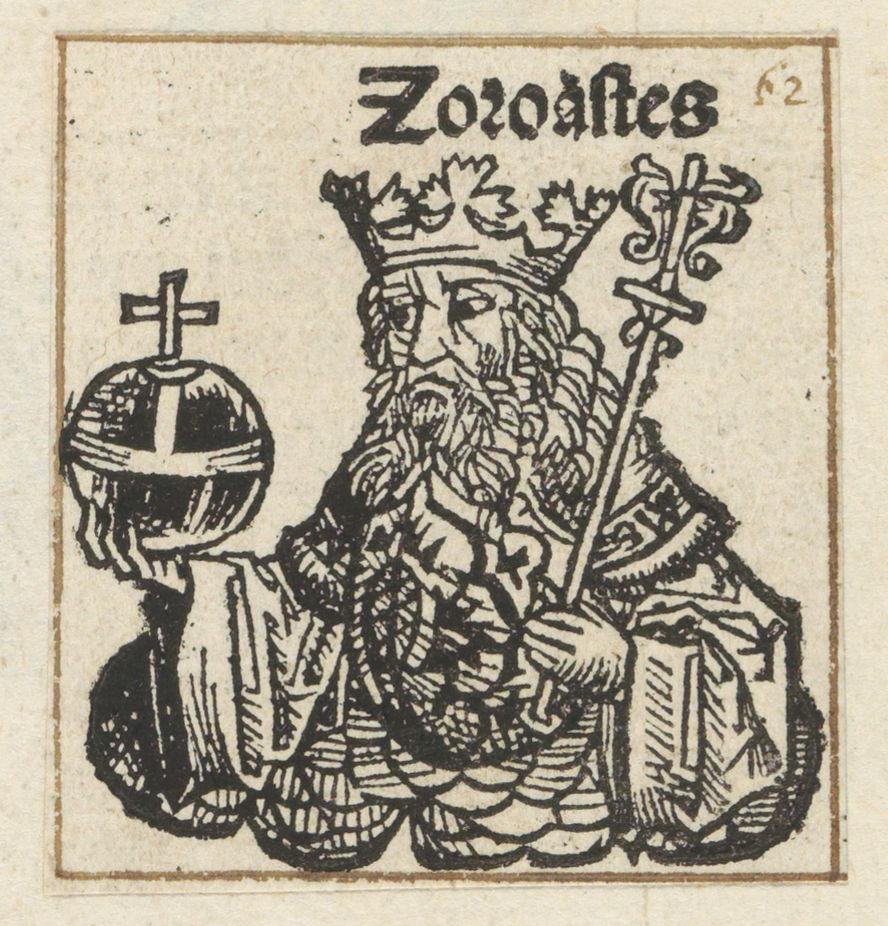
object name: print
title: Zoroastes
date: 1493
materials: paper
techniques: letterpress printing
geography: nuremberg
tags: king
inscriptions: inscription: ‘62’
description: Een bloemkelk met een koning. Hij heeft een kroon op zijn hoofd en in zijn handen een rijksappel en een scepter. De tekst identificeert hem als Zoroaster de wijze (of Zarathustra). De prent maakt deel uit van een album.